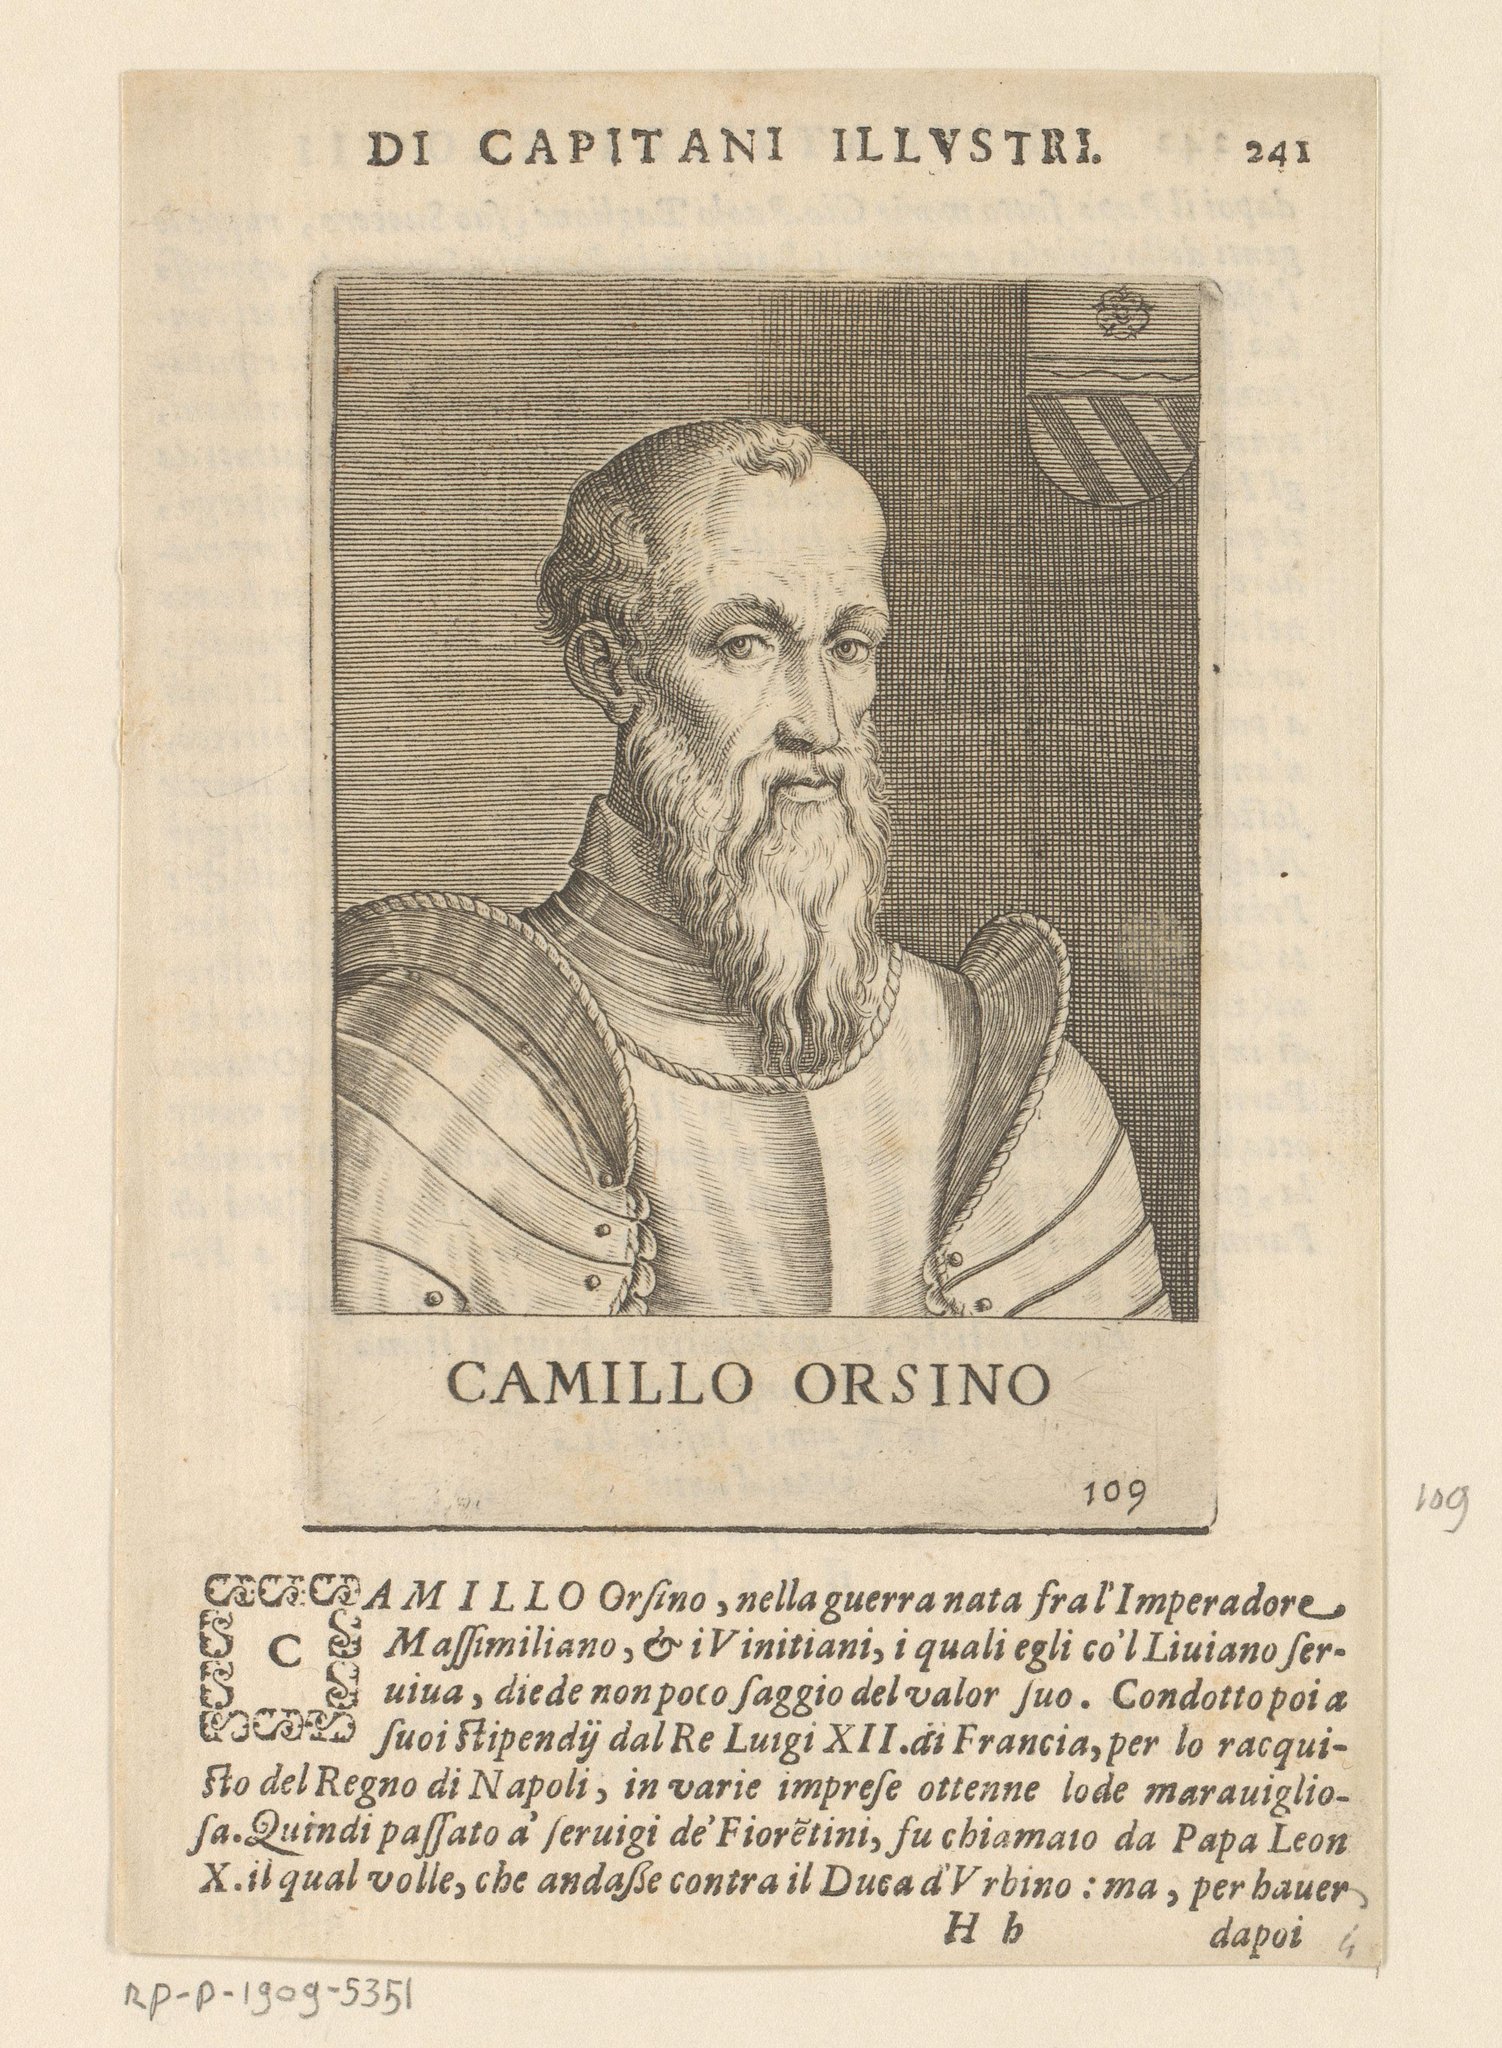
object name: print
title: Portret van Camillo Orsini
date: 1635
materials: paper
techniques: engraving, letterpress printing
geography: rome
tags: military service, historical persons, armorial bearing, heraldry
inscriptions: collector's mark: Lugt 2228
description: Prent uit: Ritratti et elogii di capitani Illustri. Rome: Pompilio Totti en Andrea Fei, 1635, p. 241. Eerdere staat van prent in ieder geval ook gebruikt in: Ritratti di cento capitani illustri con li lor Fatti in guerra (…), Rome: Domenico Gigliotti, 1596. Latere staat van prent in ieder geval ook gebruikt in: Ritratti et elogii di capitani Illustri. Che ne'secoli moderni hanno gloriosamente guerreggiato. Rome: Filippo de'Rossi en Vitale Mascardi, 1646.